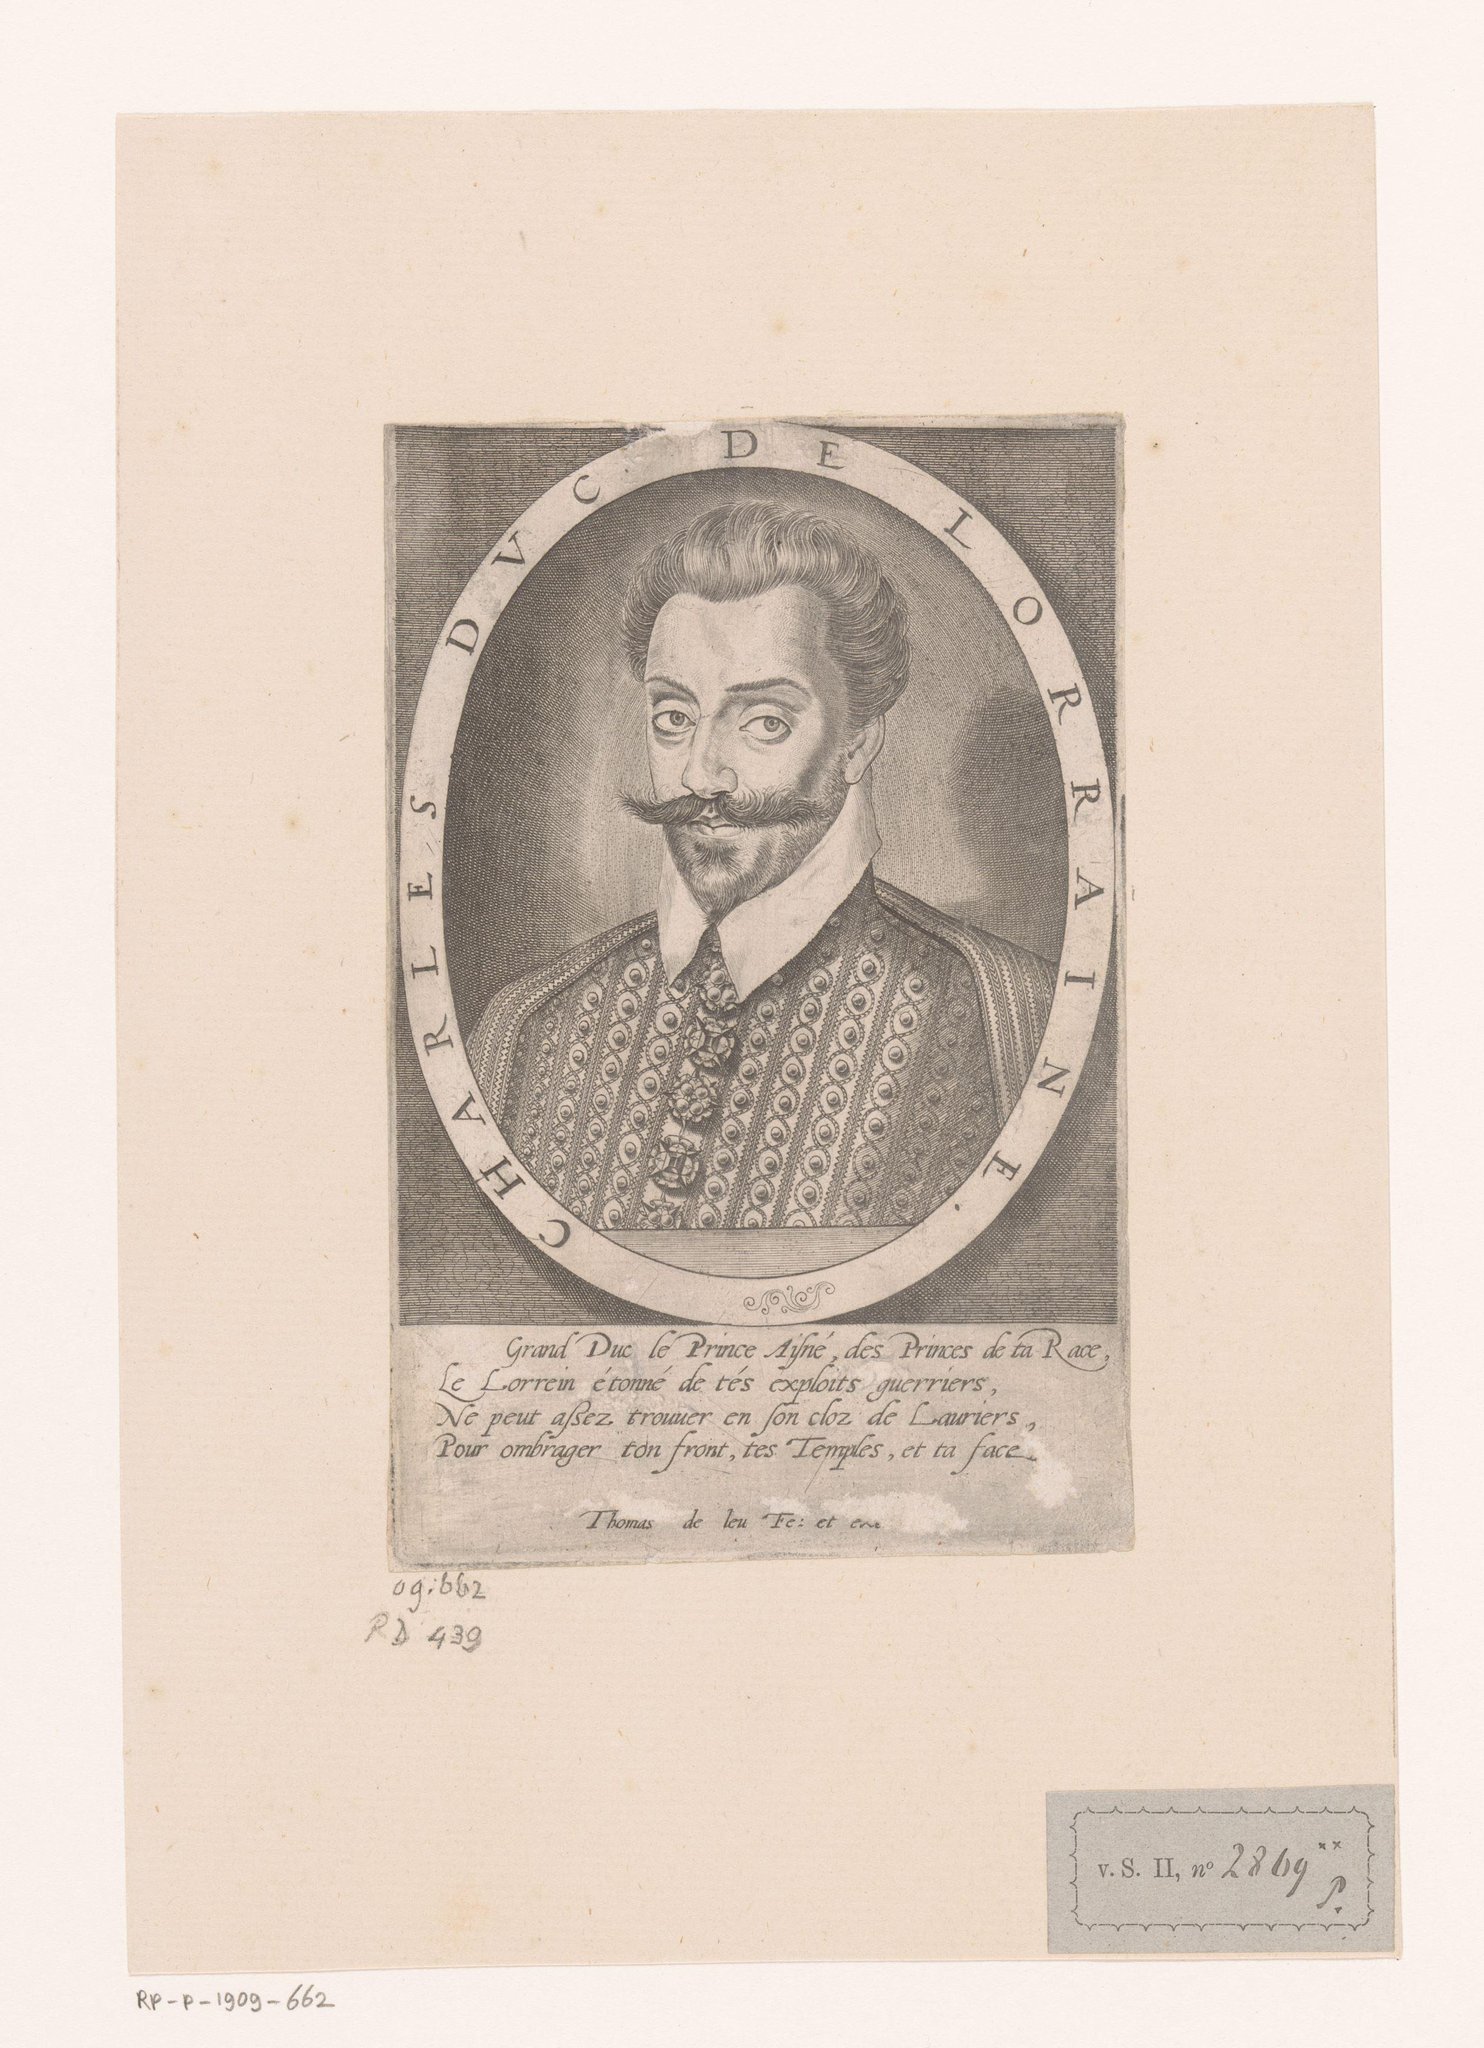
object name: print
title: Portret van Karel III, hertog van Lotharingen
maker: thomas de leu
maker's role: print maker, publisher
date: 1576-1614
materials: paper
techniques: engraving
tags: historical persons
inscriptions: collector's mark: Lugt 2228